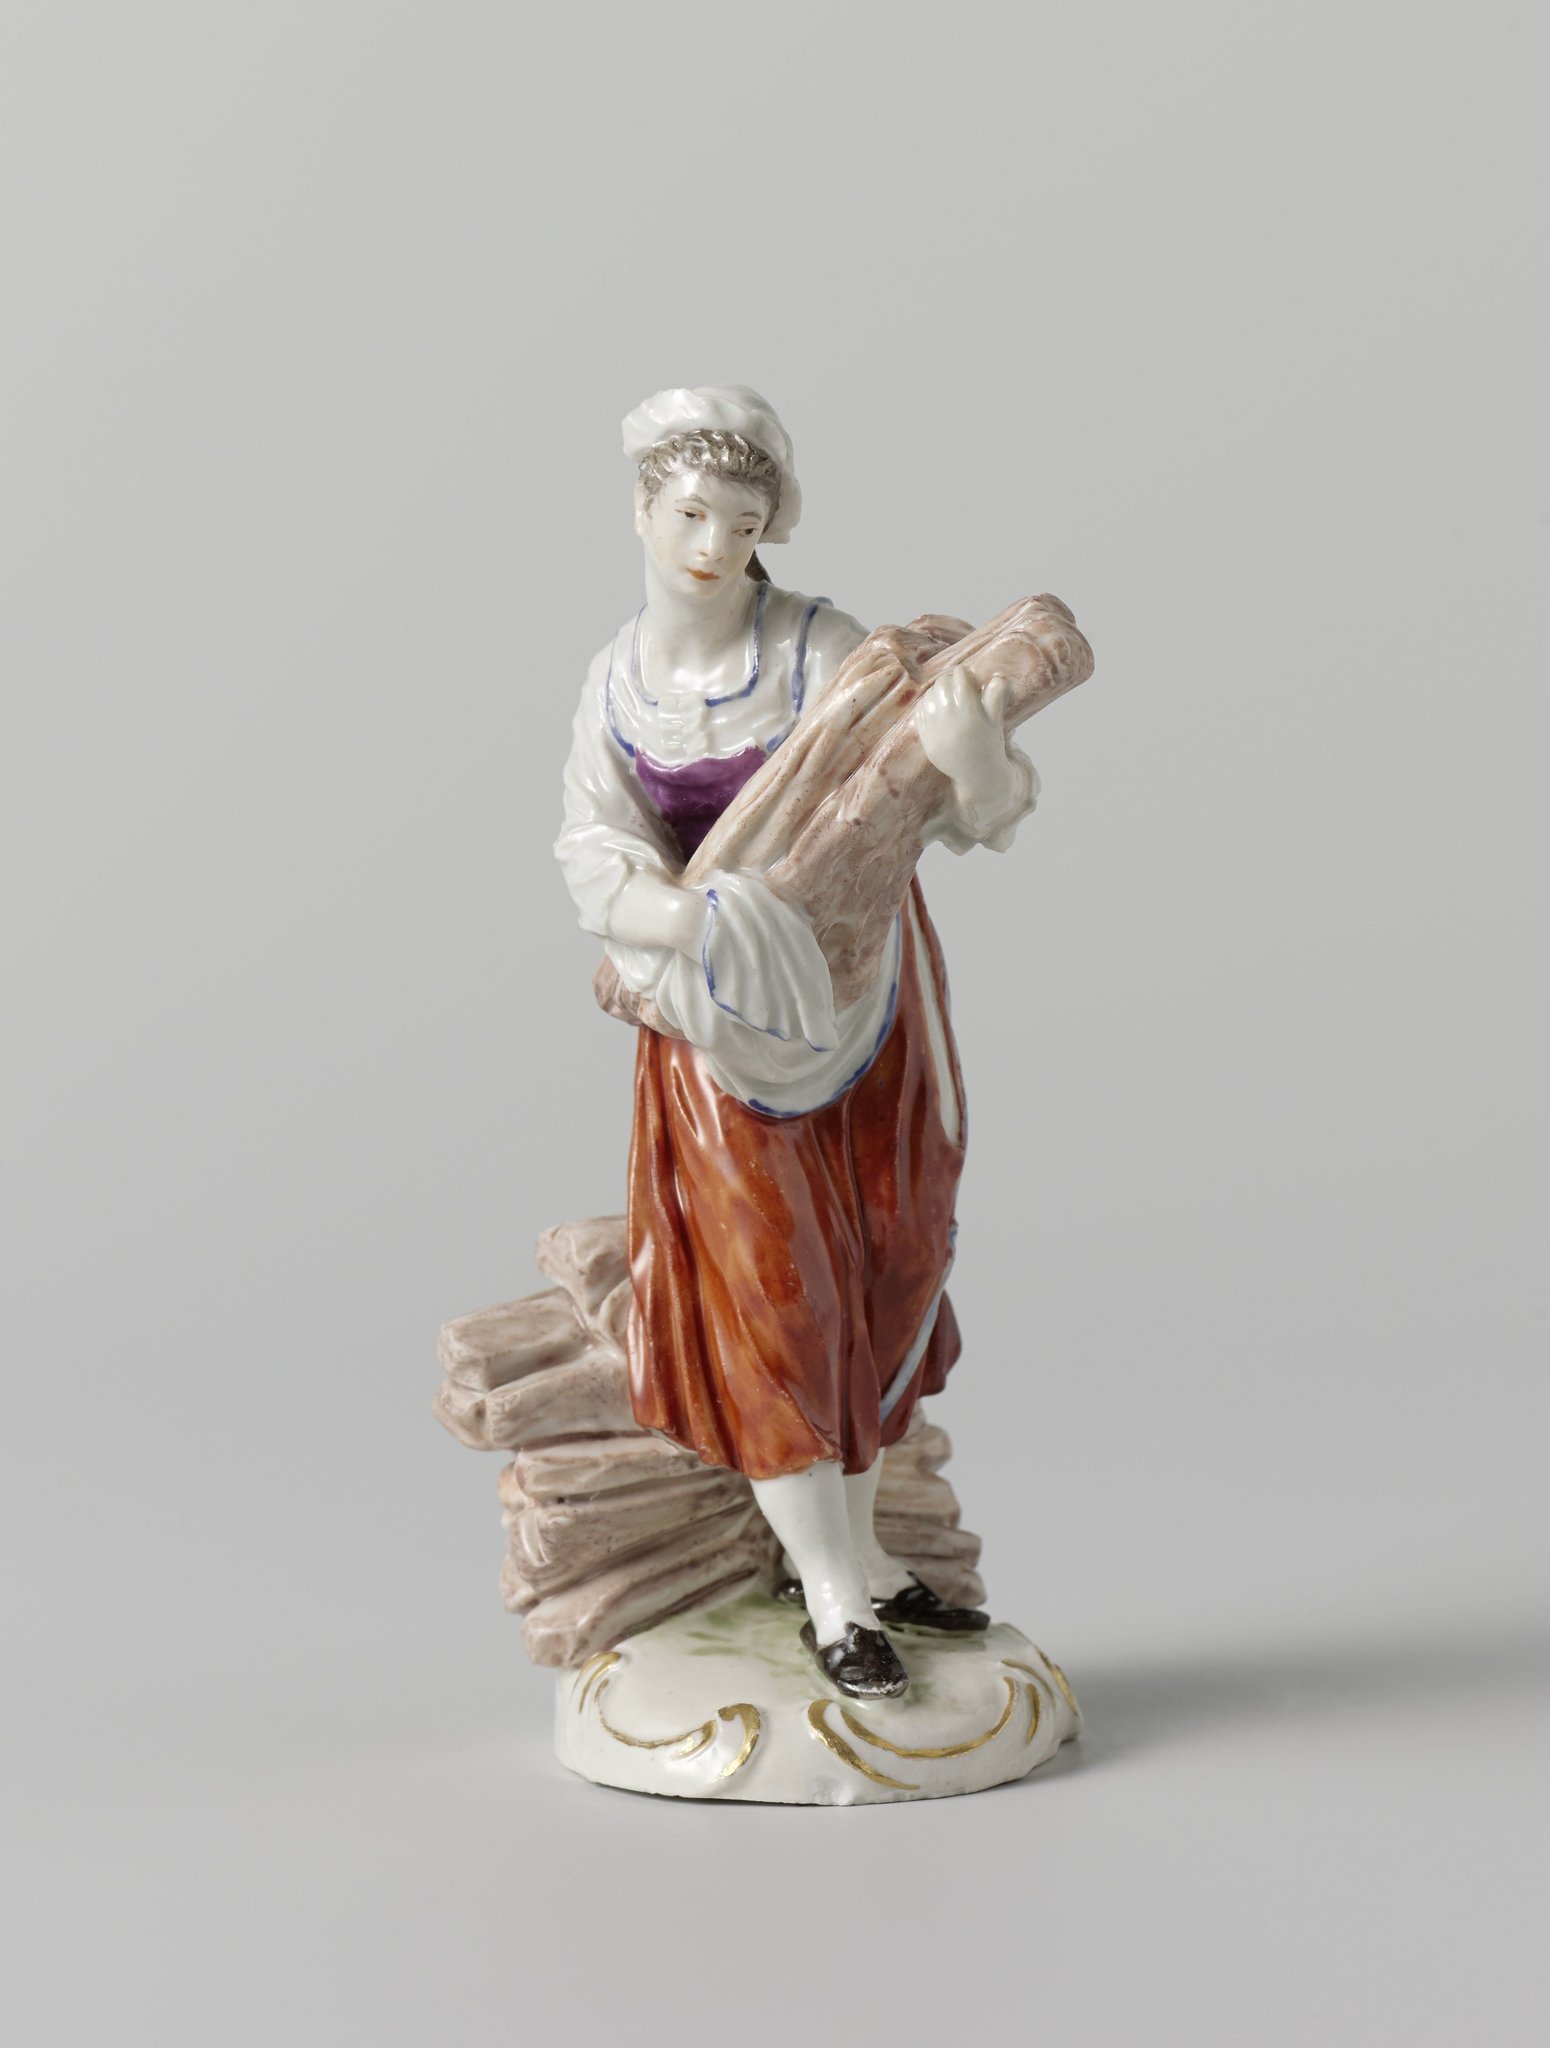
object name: figure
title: Figure of a woman carrying lumber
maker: jean jacob louis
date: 1763-1765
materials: glaze, gold, paint, porcelain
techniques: firing, forming, gilding, vitrification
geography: ludwigsburg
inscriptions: mark: ‘gekroonde dubbele C’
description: A woodcutter's wife. Porcelain. Ludwigsburg, c. 1763 - 1765, model attributed to Jean Jacques Louis.